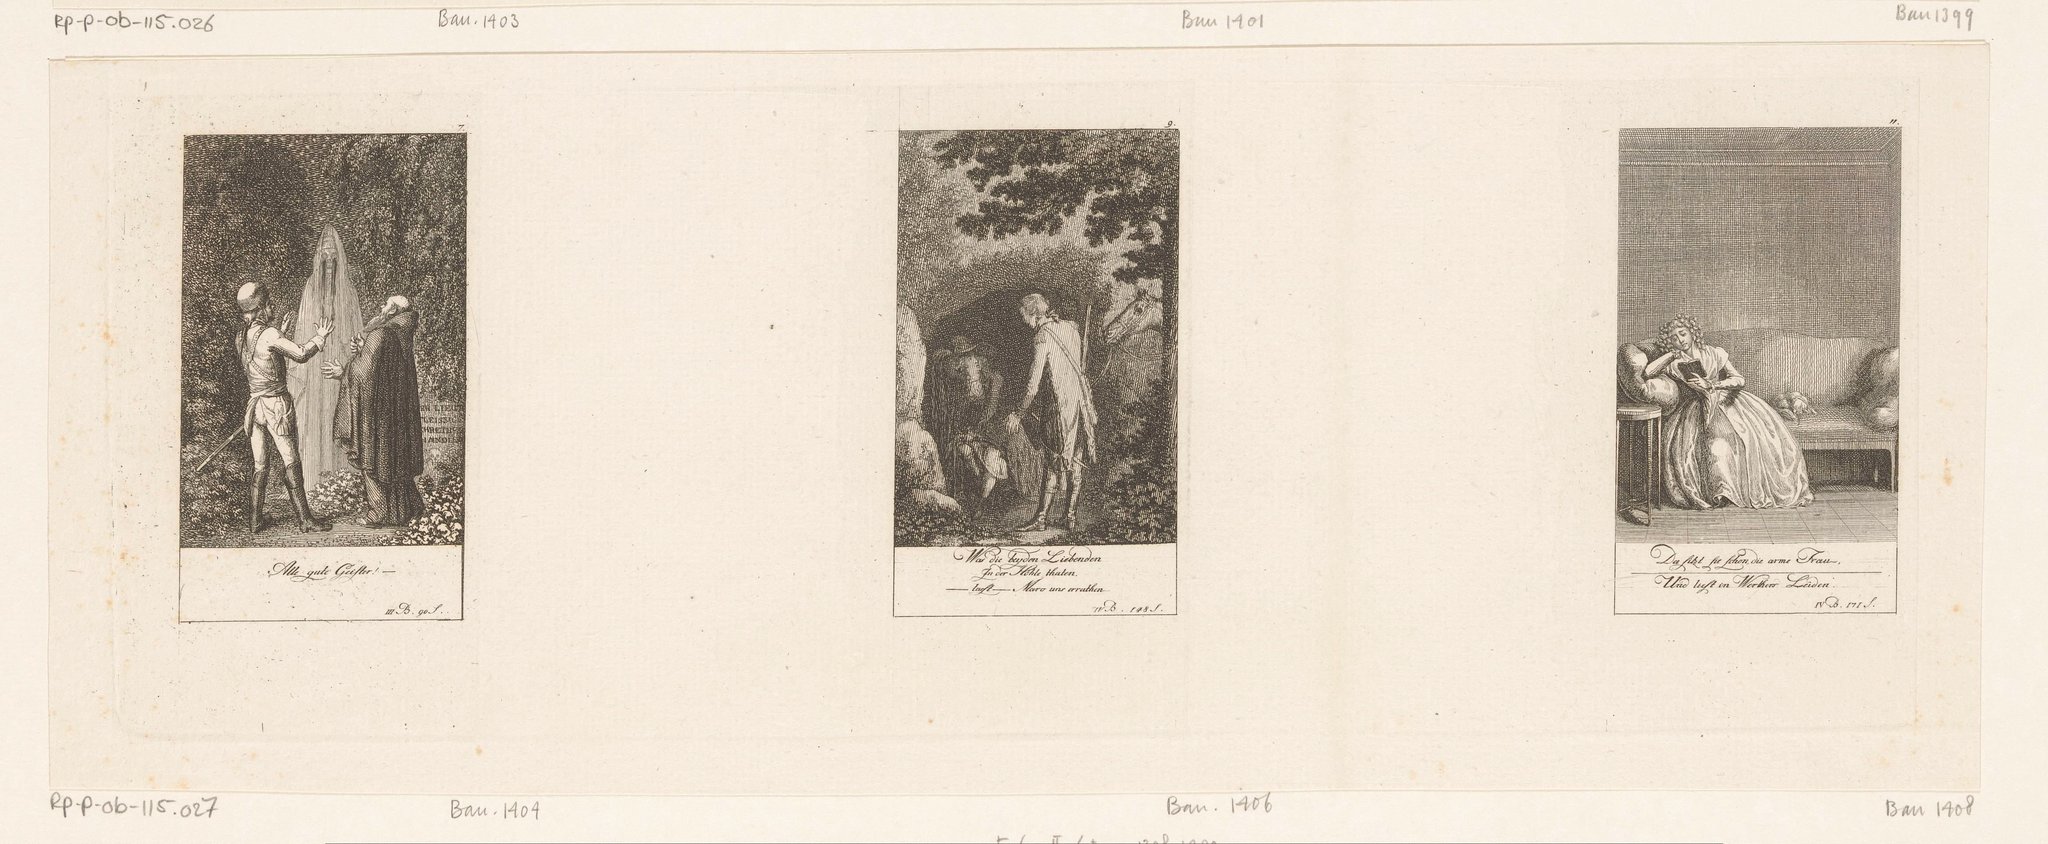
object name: book illustration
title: Drie voorstellingen uit Blumauers Aeneide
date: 1789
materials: paper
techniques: etching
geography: lauenburg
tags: vienna, alois blumauer, literature, monk(s), friar(s), grave, tomb, (story of) aeneas, spirit, ghost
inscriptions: collector's mark: Lugt 2228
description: Vervaardigd voor Johann Aloys Blumauers 'Aeneide'. Prenten gebruikt voor: Königl. Grossbrit. Genealogischer Kalender auf das Jahr 1790. Lauenburg: J. G. Berenberg, [1789].